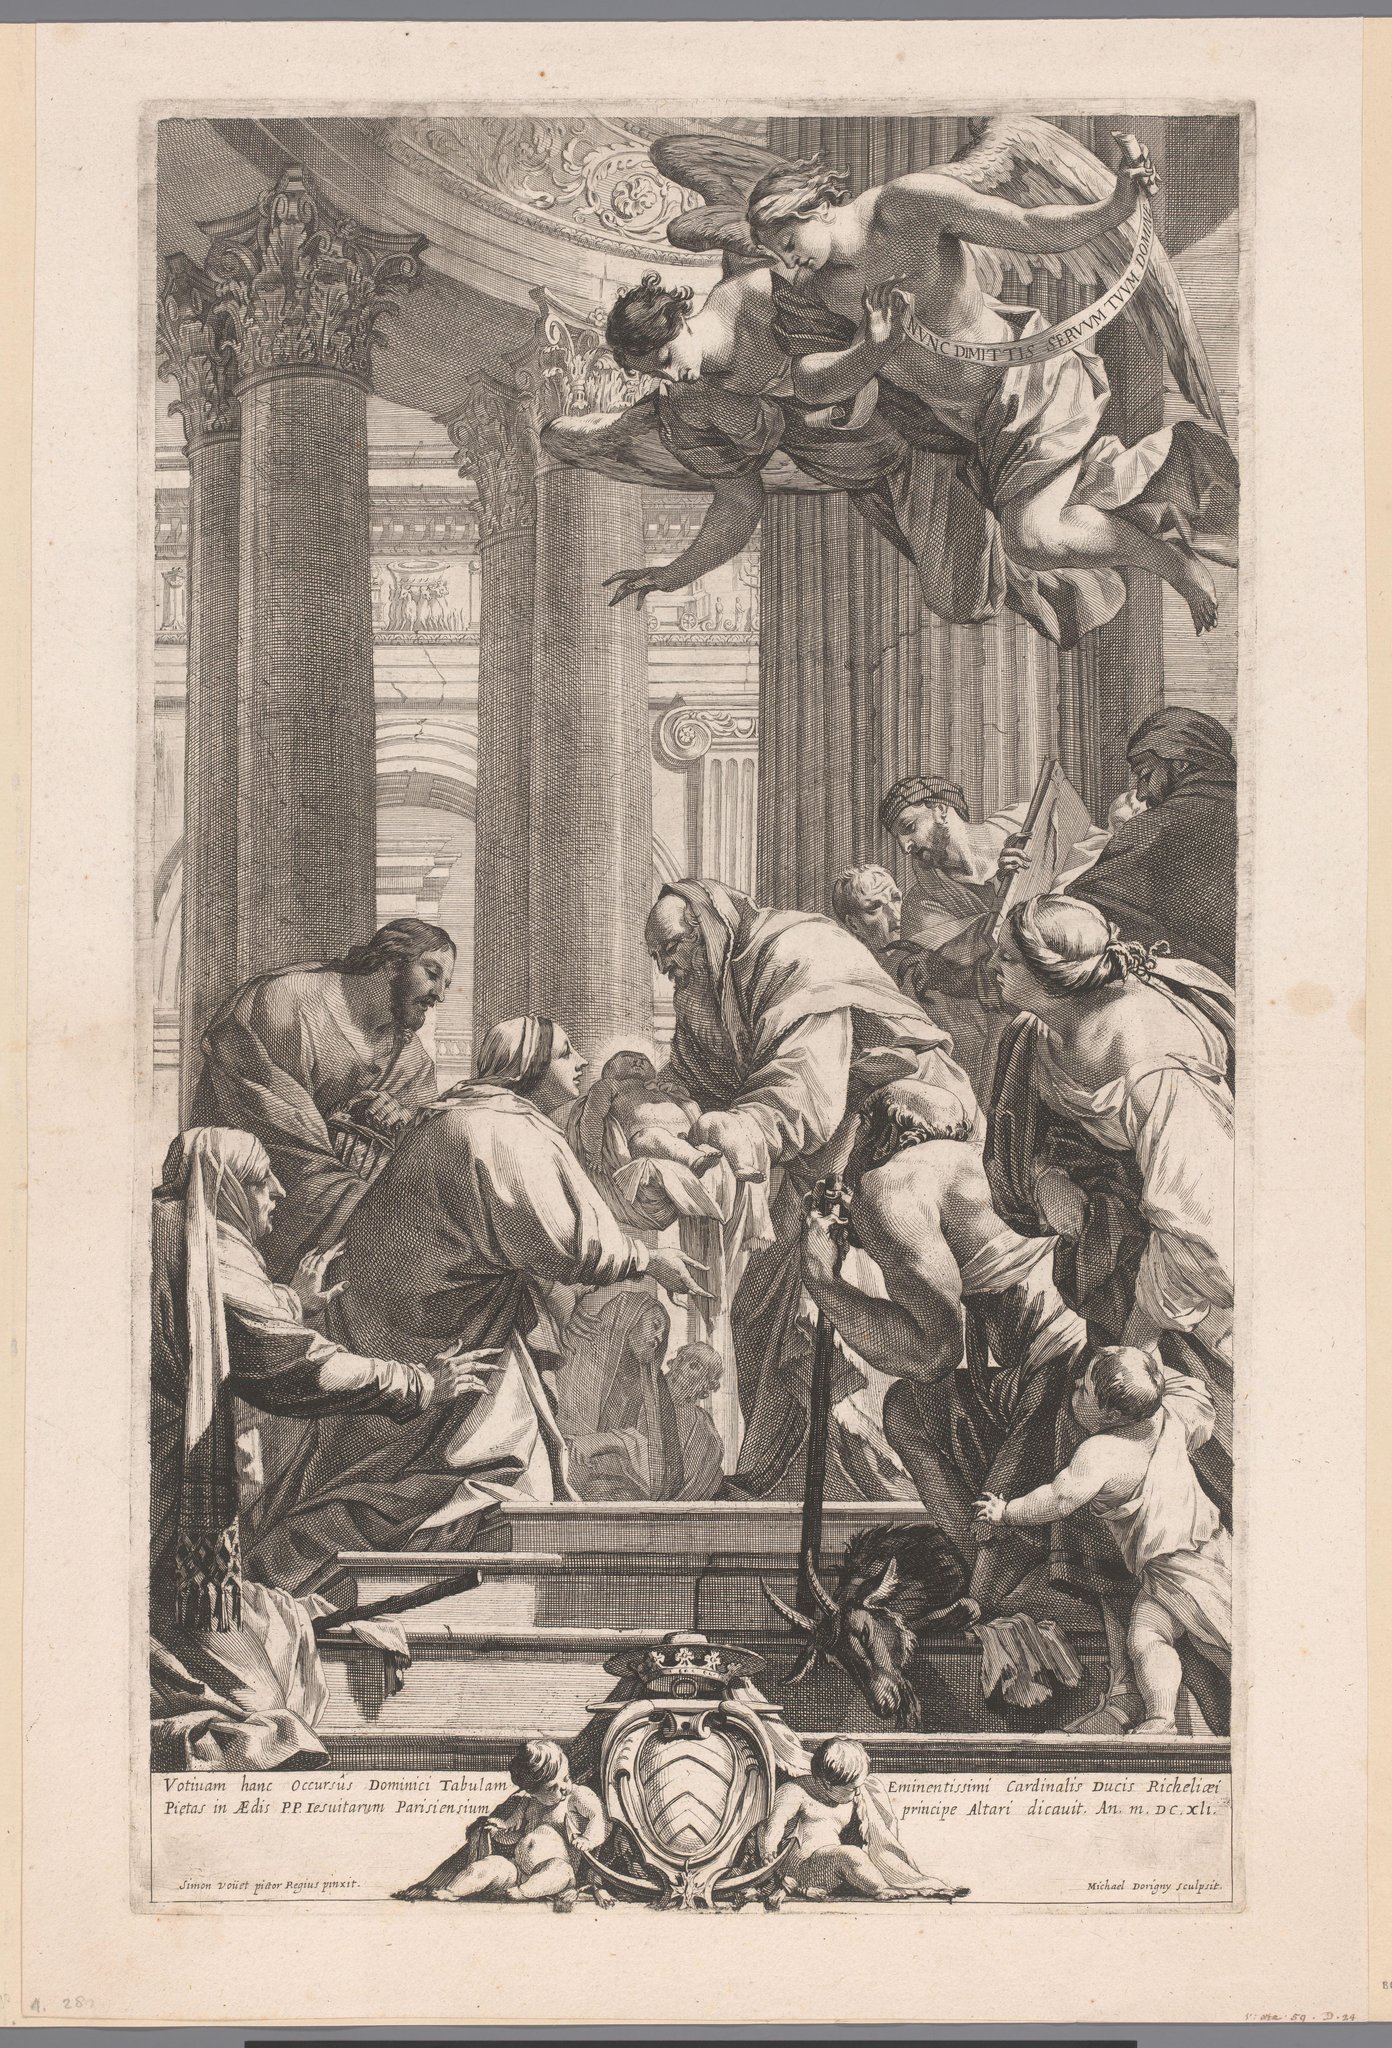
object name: print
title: Presentatie in de tempel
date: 1641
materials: paper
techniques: engraving, etching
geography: france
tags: presentation of the christ-child in the temple, usually simeon (and anna) present (luke 2:22-39)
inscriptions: collector's mark: Lugt 240